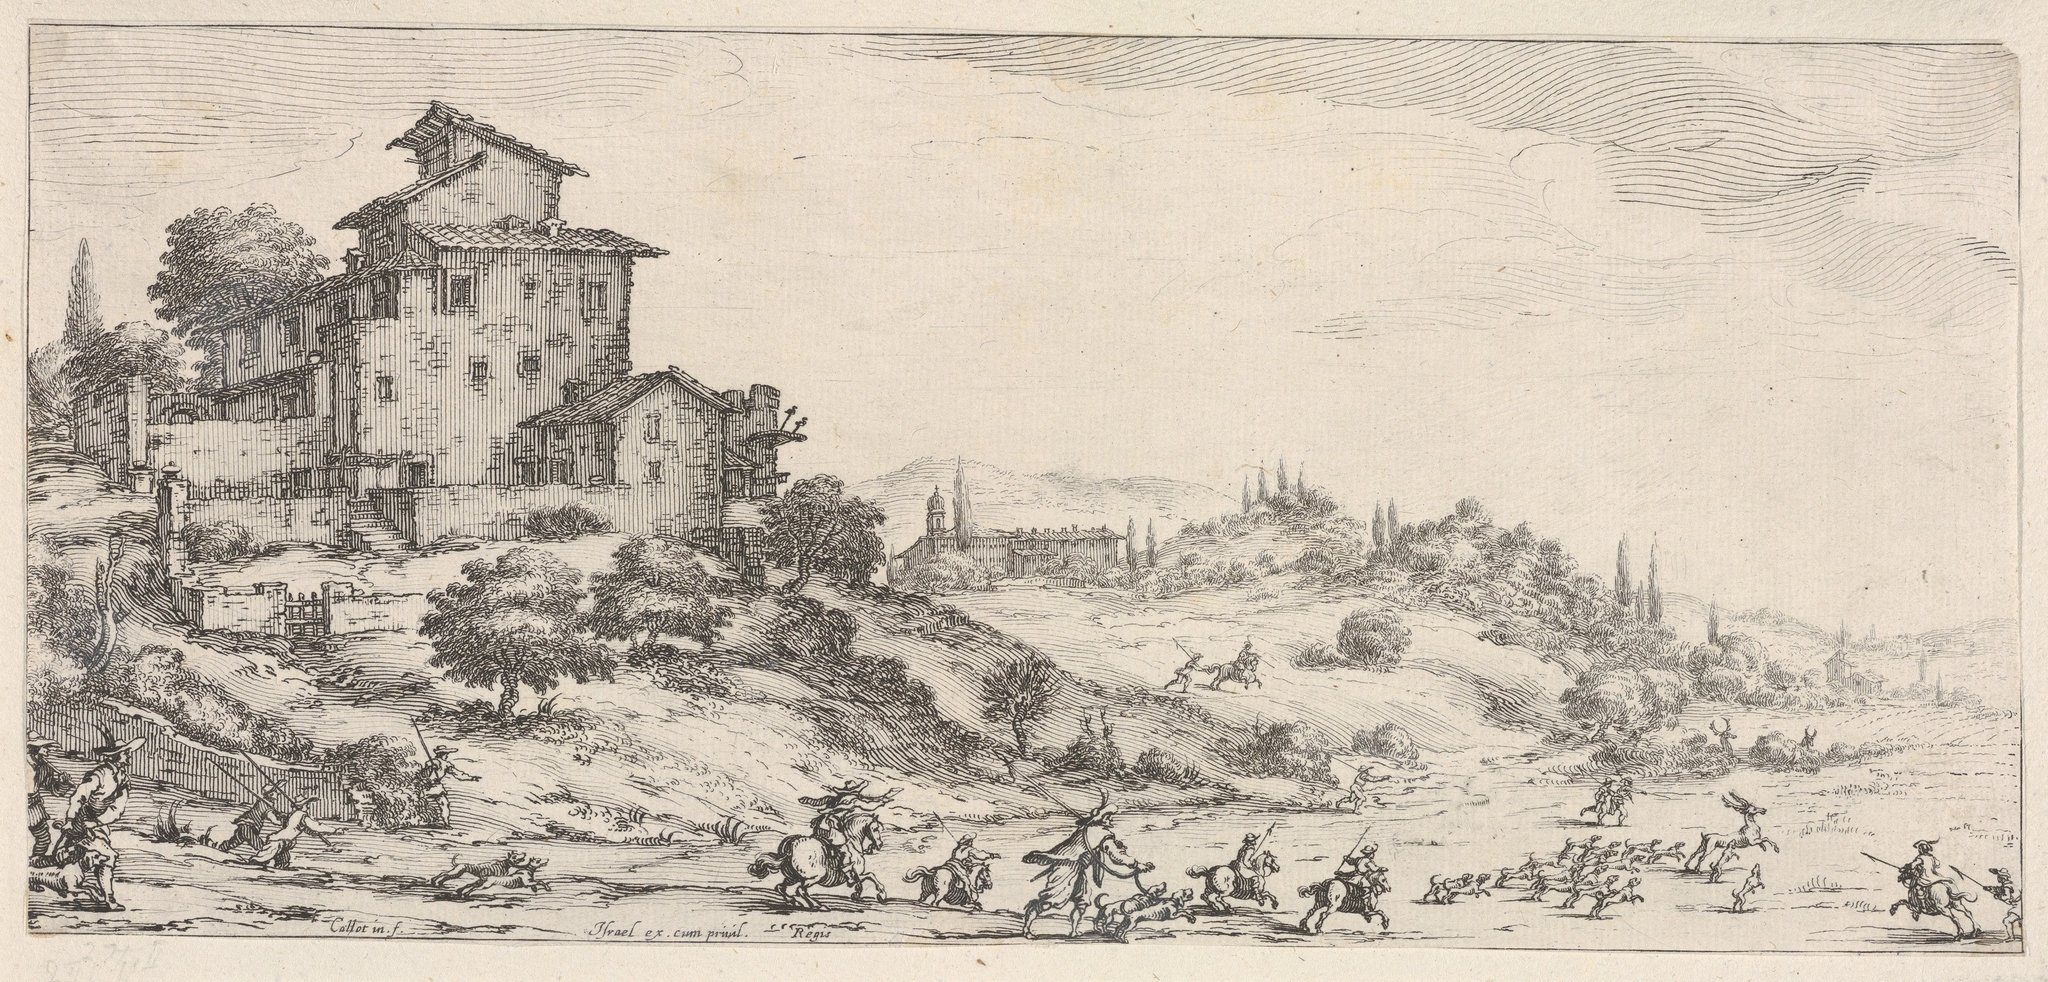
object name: print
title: Hunters on horses and on foot, with hounds pursuing a stag, and two buildings in a hilly landscape, from "Italian landscapes" (Diverse vedute designate in Fiorenza / Paysages italiens)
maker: jacques callot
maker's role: artist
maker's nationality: french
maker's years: 1592-1635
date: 1618-1635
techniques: etching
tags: buildings,men,hunting,horses,landscapes